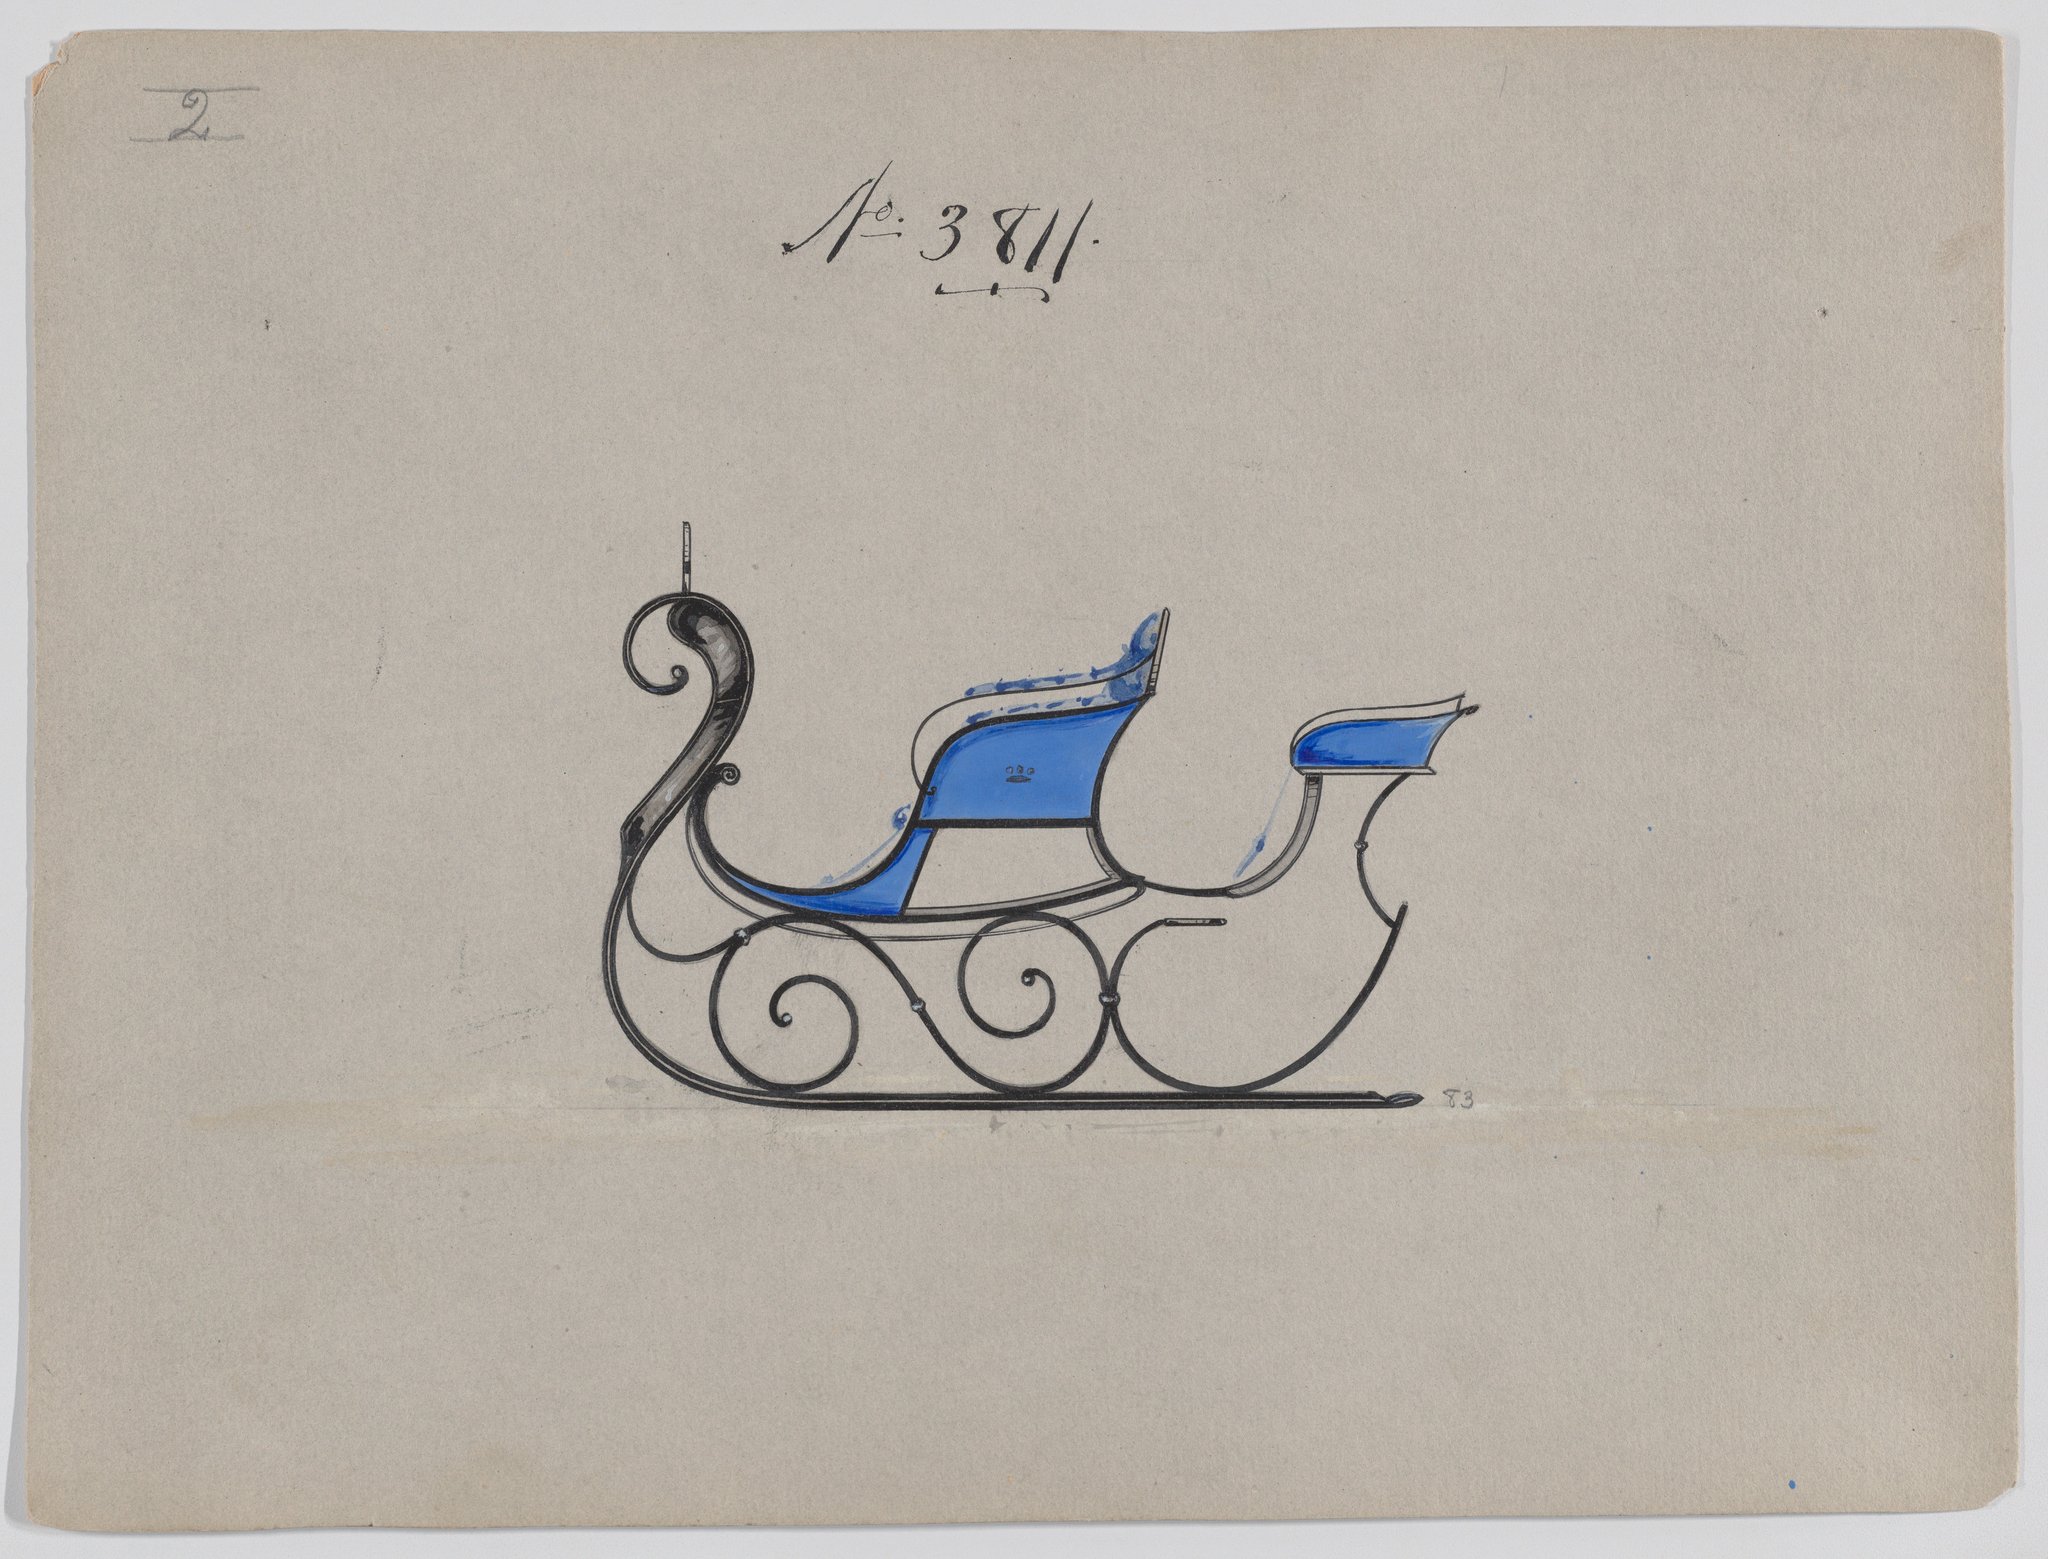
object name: drawing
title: Currical Sleigh with Rumble Seat # 3811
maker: brewster & co.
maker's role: manufacturer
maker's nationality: american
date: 1883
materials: gouache, ink, watercolor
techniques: pen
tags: sleighs